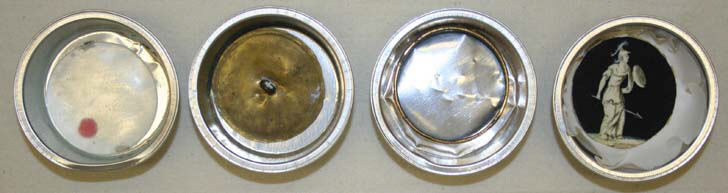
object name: button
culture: french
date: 1775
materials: glass, ivory